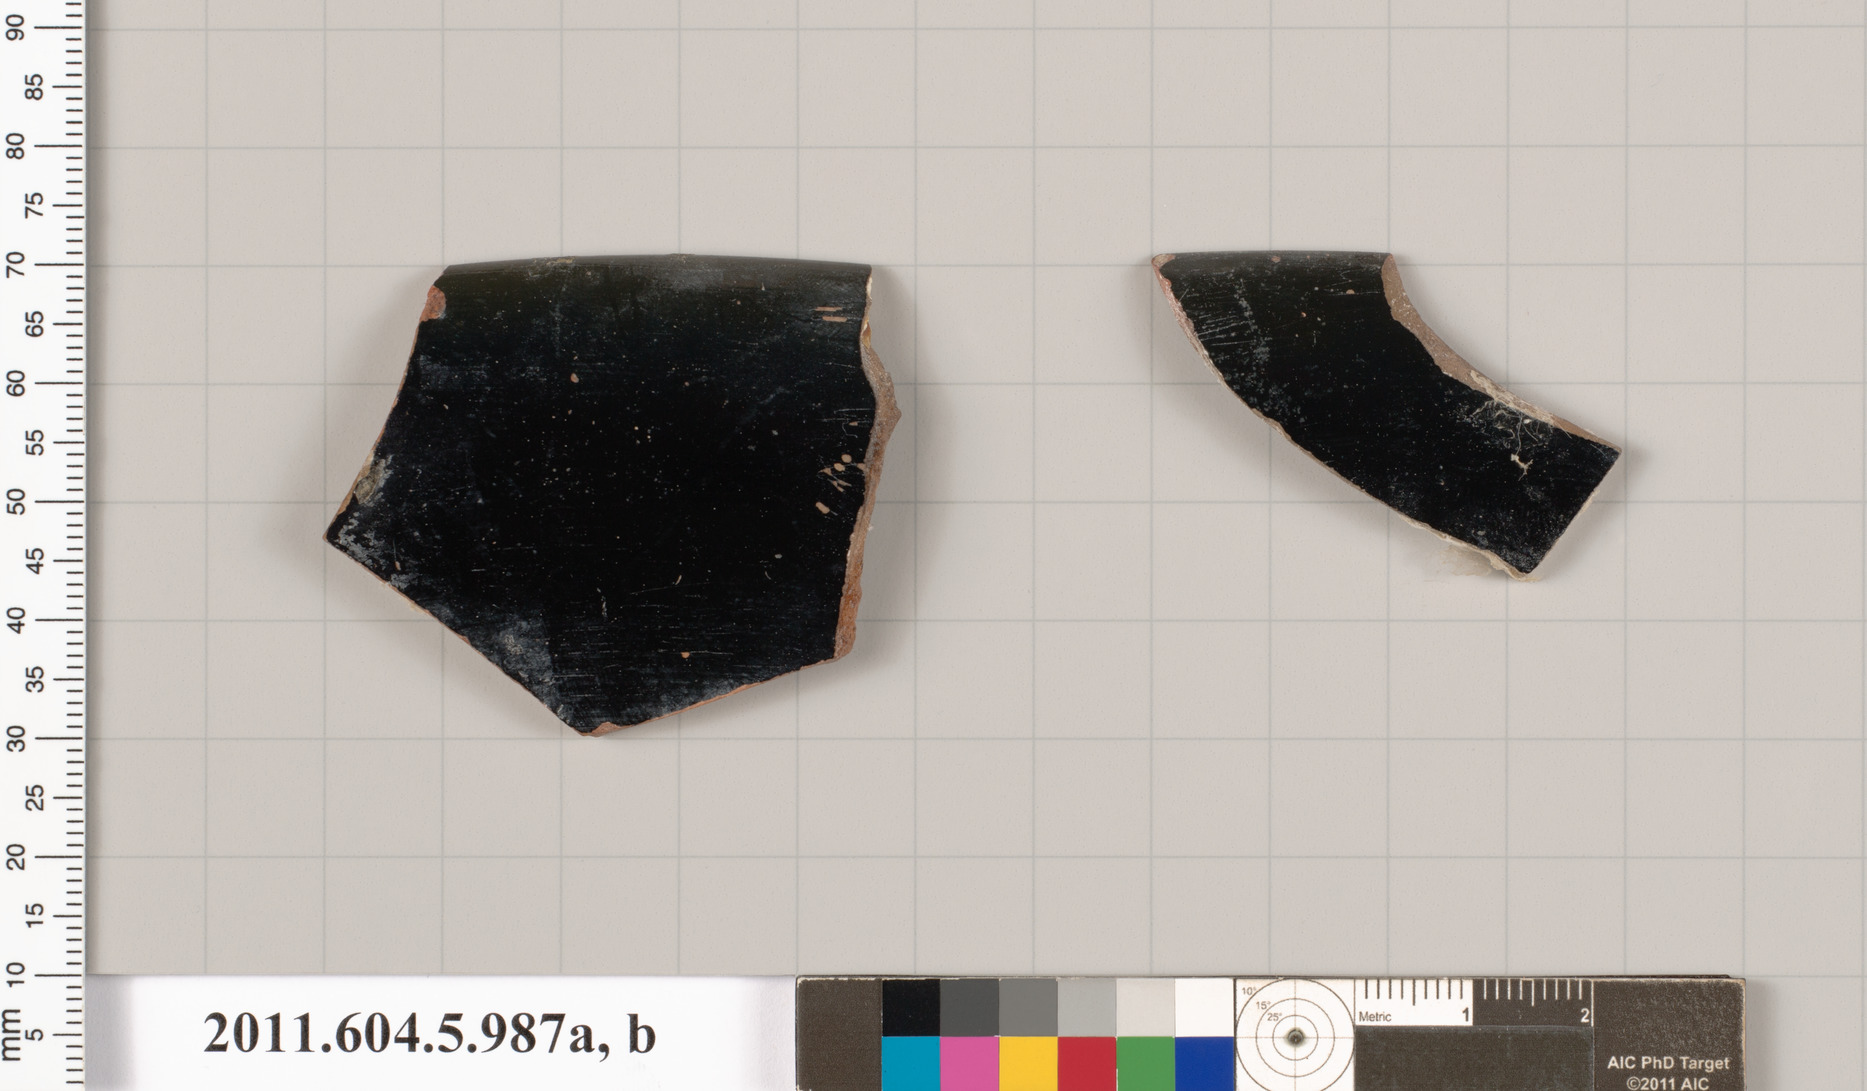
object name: kylix fragment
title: Terracotta rim fragments of kylikes (drinking cups)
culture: greek, attic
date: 600-401 BCE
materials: terracotta